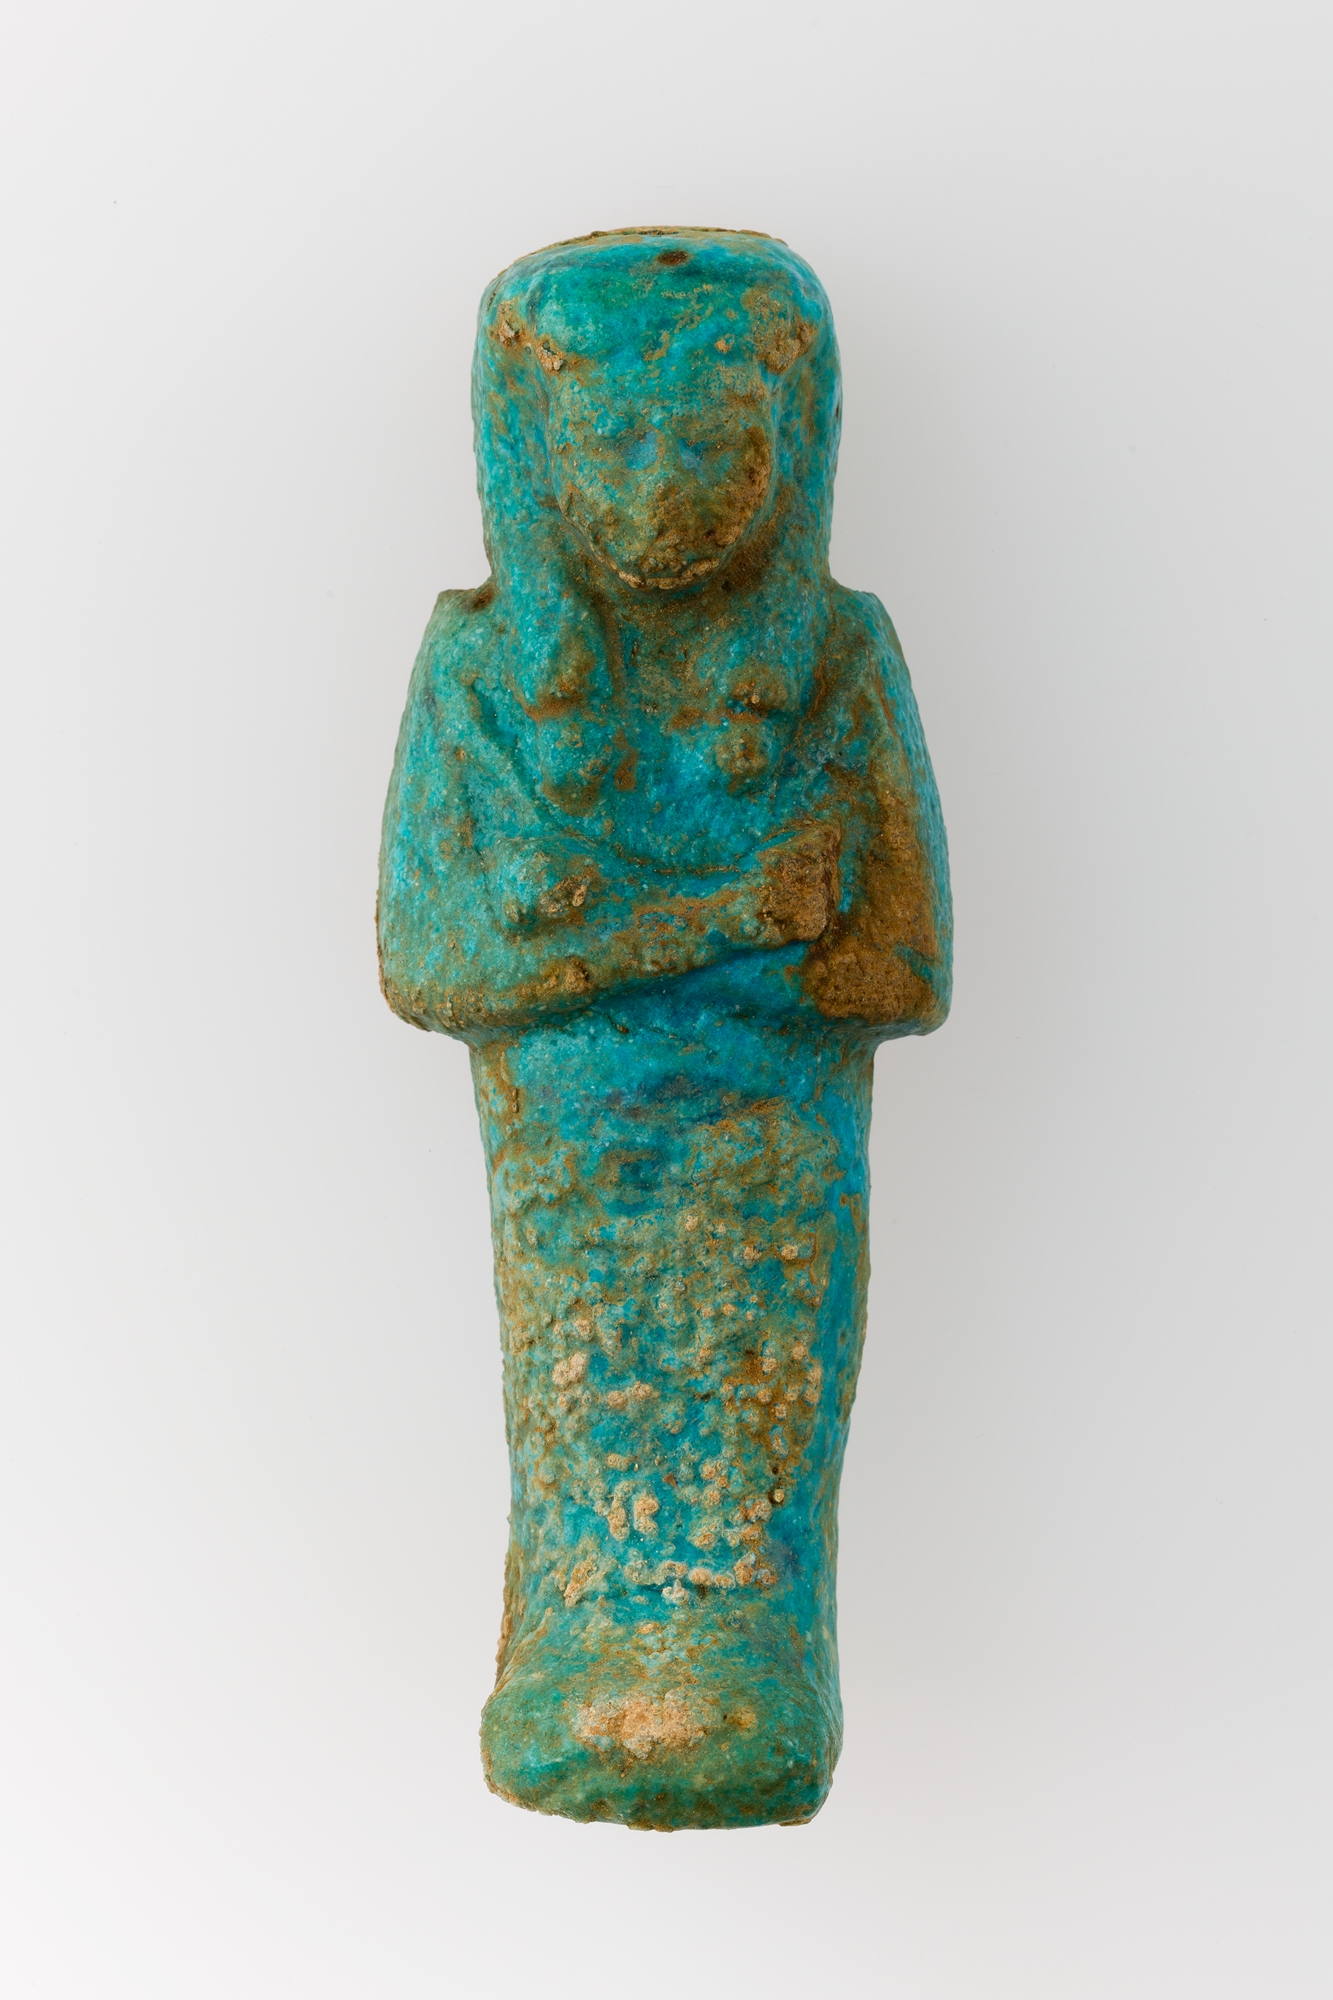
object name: shabti, henettawy c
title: Worker Shabti of Henettawy (C), Daughter of Isetemkheb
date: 990-970 BCE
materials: faience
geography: egypt